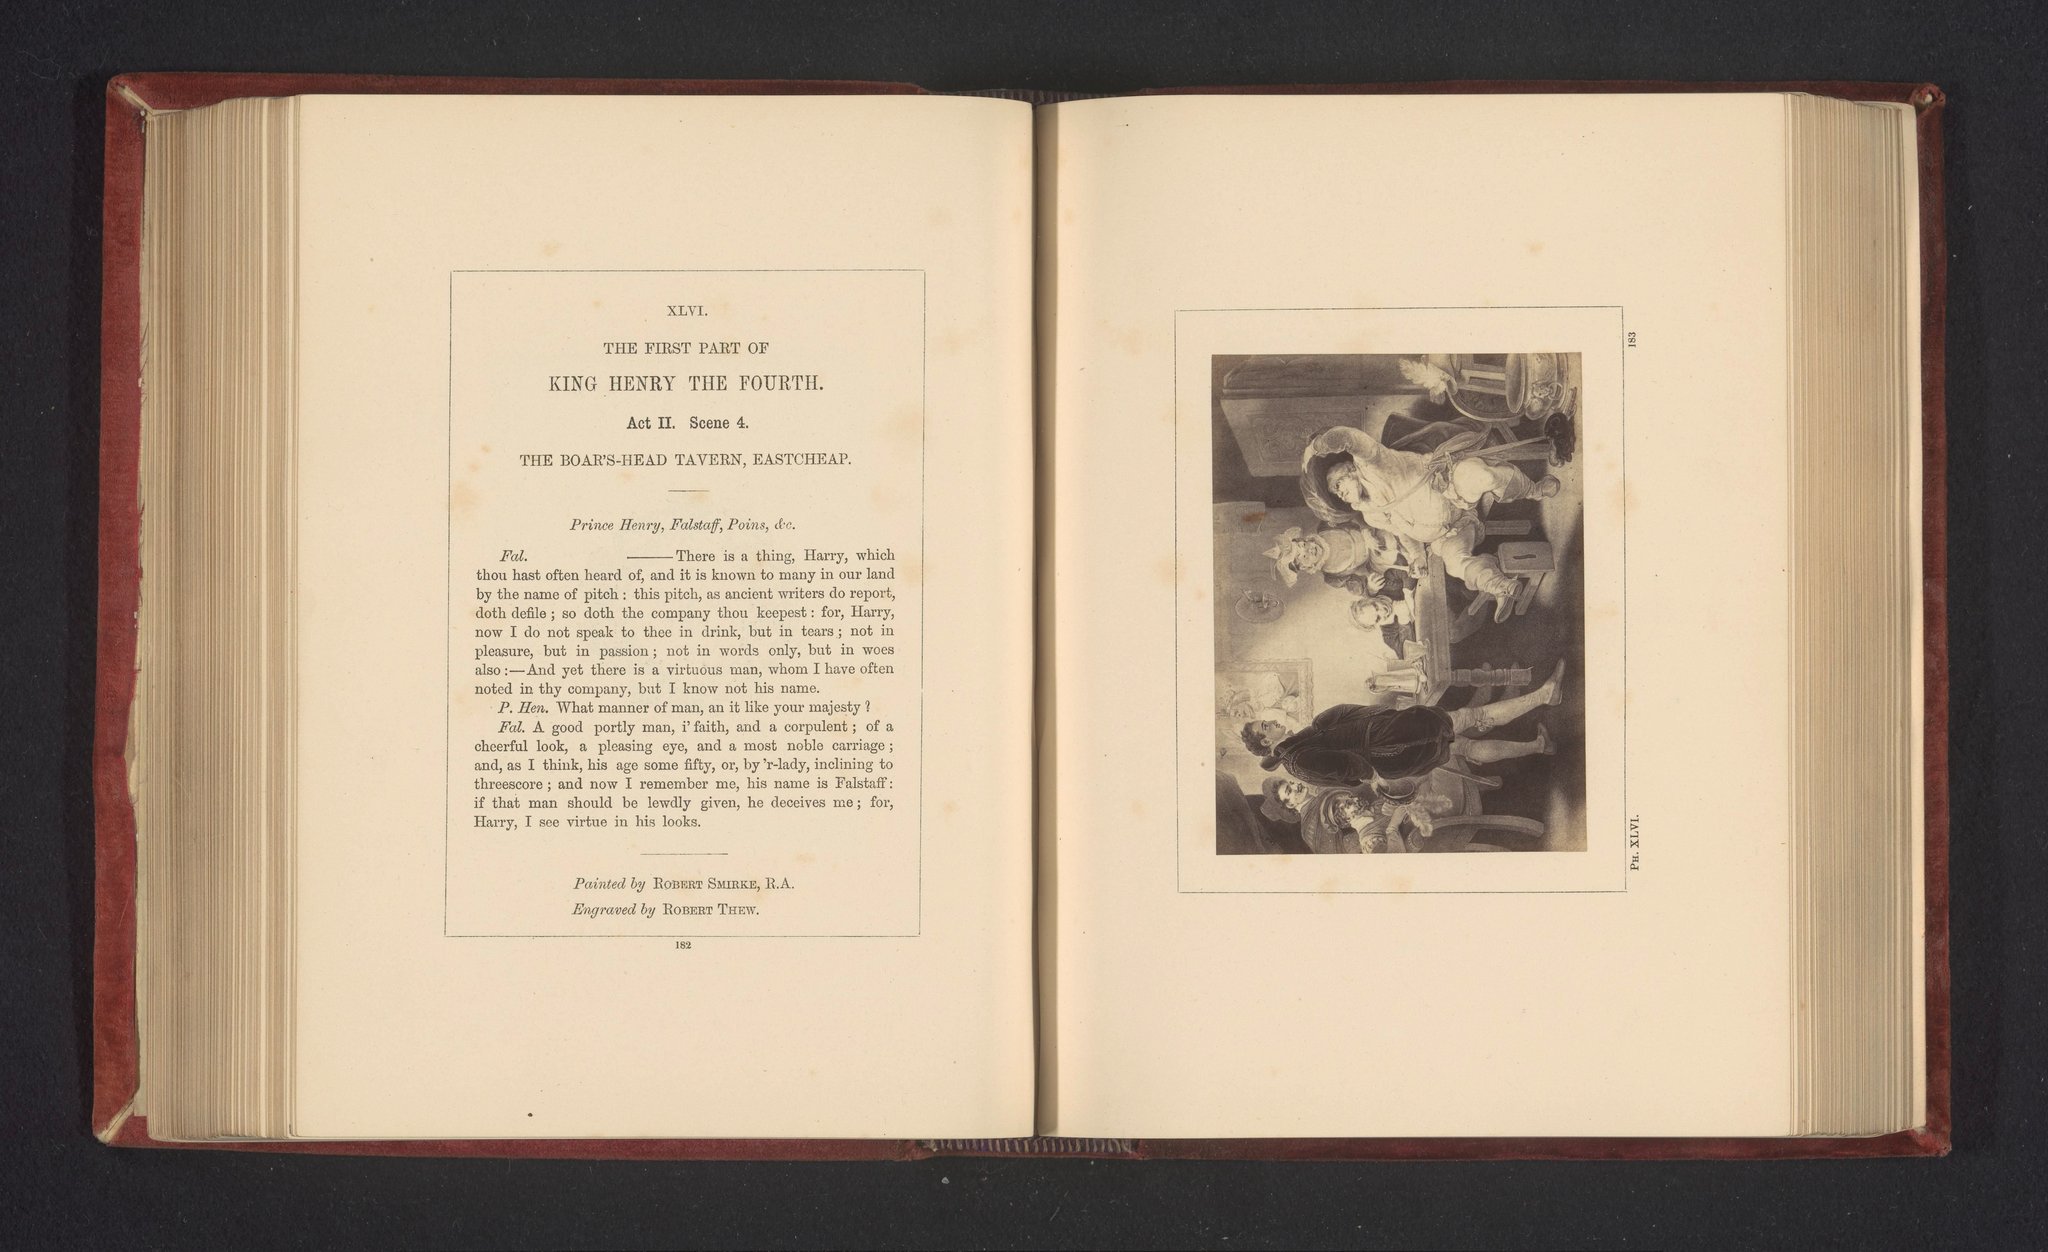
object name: reproduction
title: Fotoreproductie van een prent naar een schilderij door Robert Smirke, voorstellend een scene uit Hendrik IV door William Shakespeare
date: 1854-1864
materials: photographic support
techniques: albumen print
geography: london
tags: specific works of literature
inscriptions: number: ‘Ph. XLVI. 183’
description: Te zien is akte II, scene 4 met prins Hendrik, Sir John Falstaff en Edward Poins in een herberg.